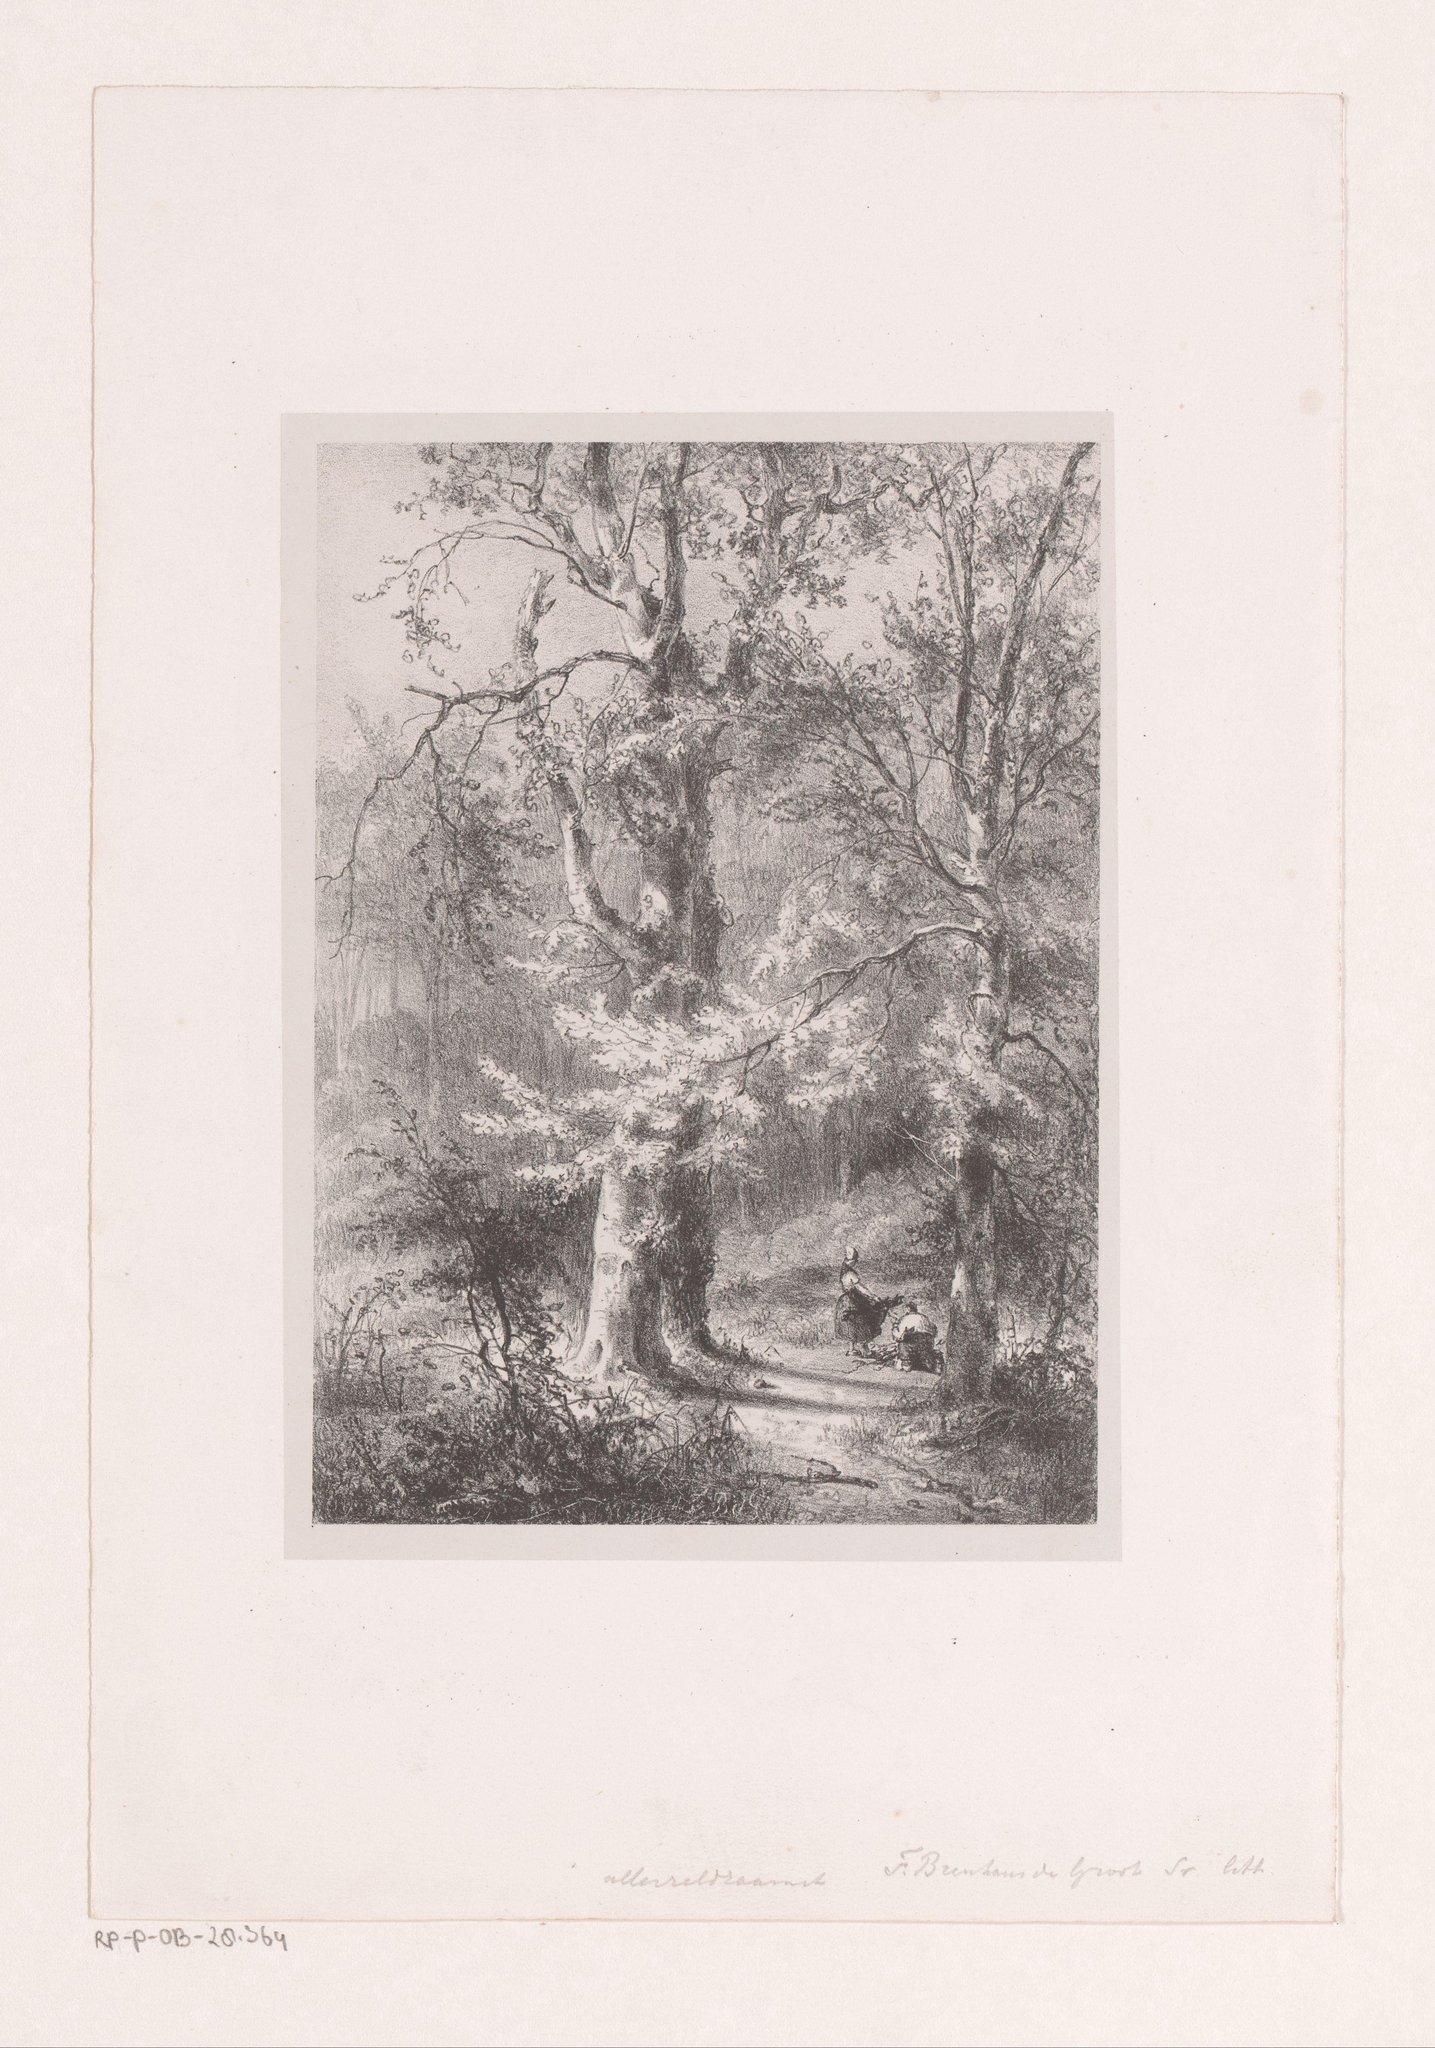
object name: print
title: Houtsprokkelaars in het bos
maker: frans breuhaus de groot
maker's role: draughtsman, print maker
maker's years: 1796-1875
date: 1809-1875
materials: paper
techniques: lithograph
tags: woodgathering, woodgatherer, forest, wood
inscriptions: collector's mark: Lugt 2228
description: De man zit gebukt op een pad in het bos bij een bos hout. De vrouw staat ernaast.